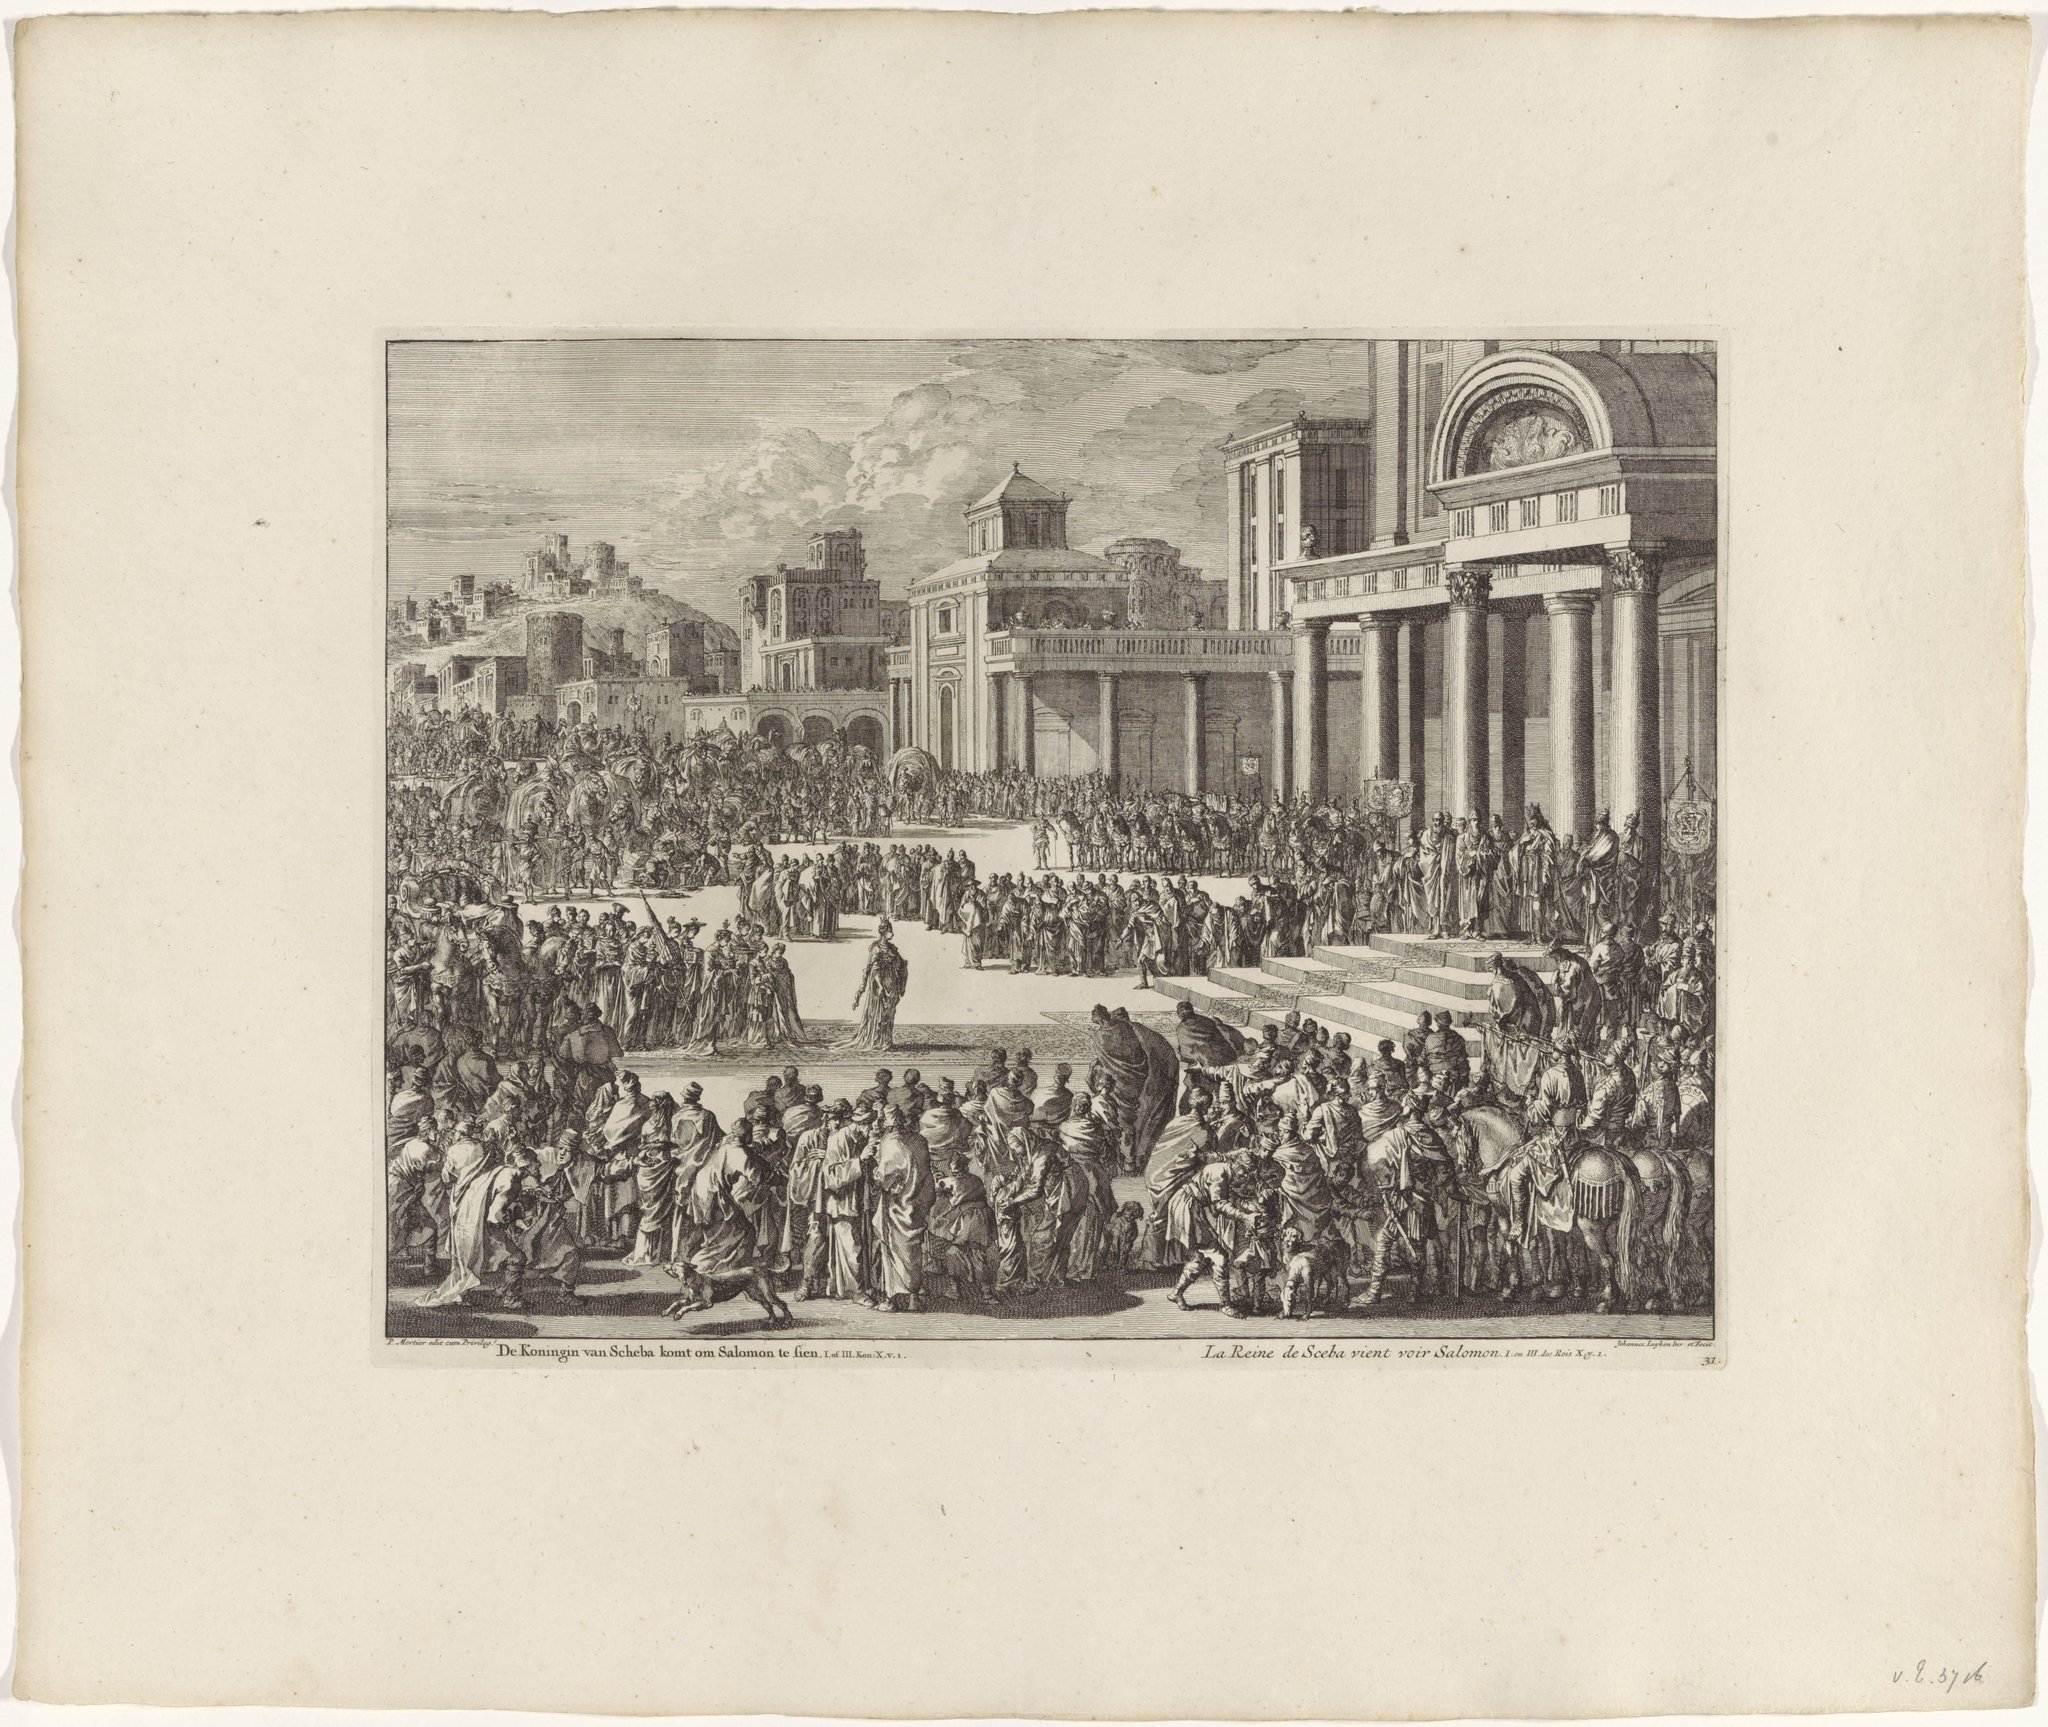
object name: book illustration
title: De Koningin van Scheba komt om Salomon te sien.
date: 1708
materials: paper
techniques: etching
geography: amsterdam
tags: the queen of sheba comes to solomon with a train of camels loaded with gifts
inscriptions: collector's mark: Lugt 2228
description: De koningin van Seba loopt over een loper naar koning Salomo. Achter haar staan haar bedienden met geschenken voor Salomo.